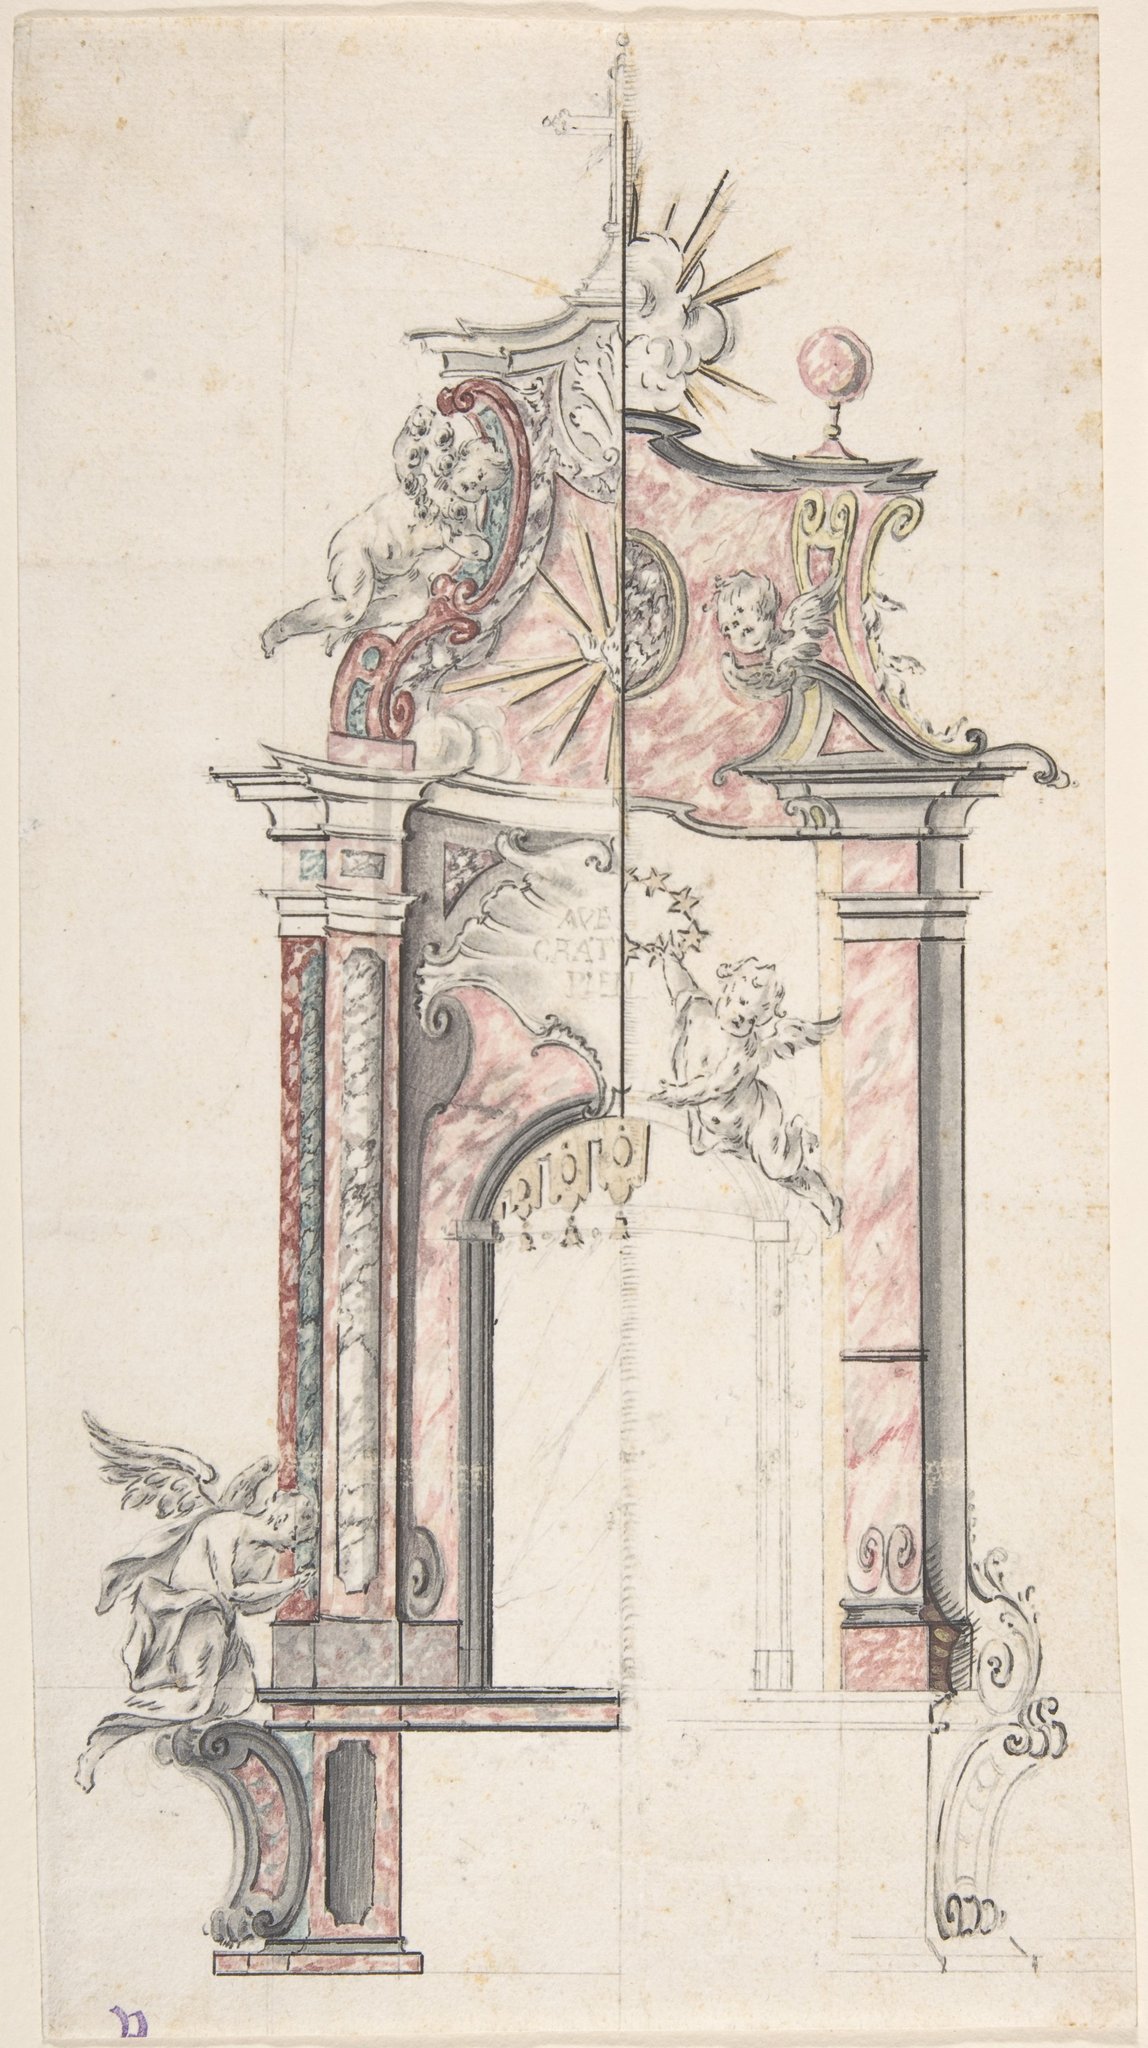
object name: drawing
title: Design for an Altar with a Variant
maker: anonymous, german, 18th century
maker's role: artist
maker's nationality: german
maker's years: 1700-1800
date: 1701-1800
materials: graphite, ink, watercolor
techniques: pen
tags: altars